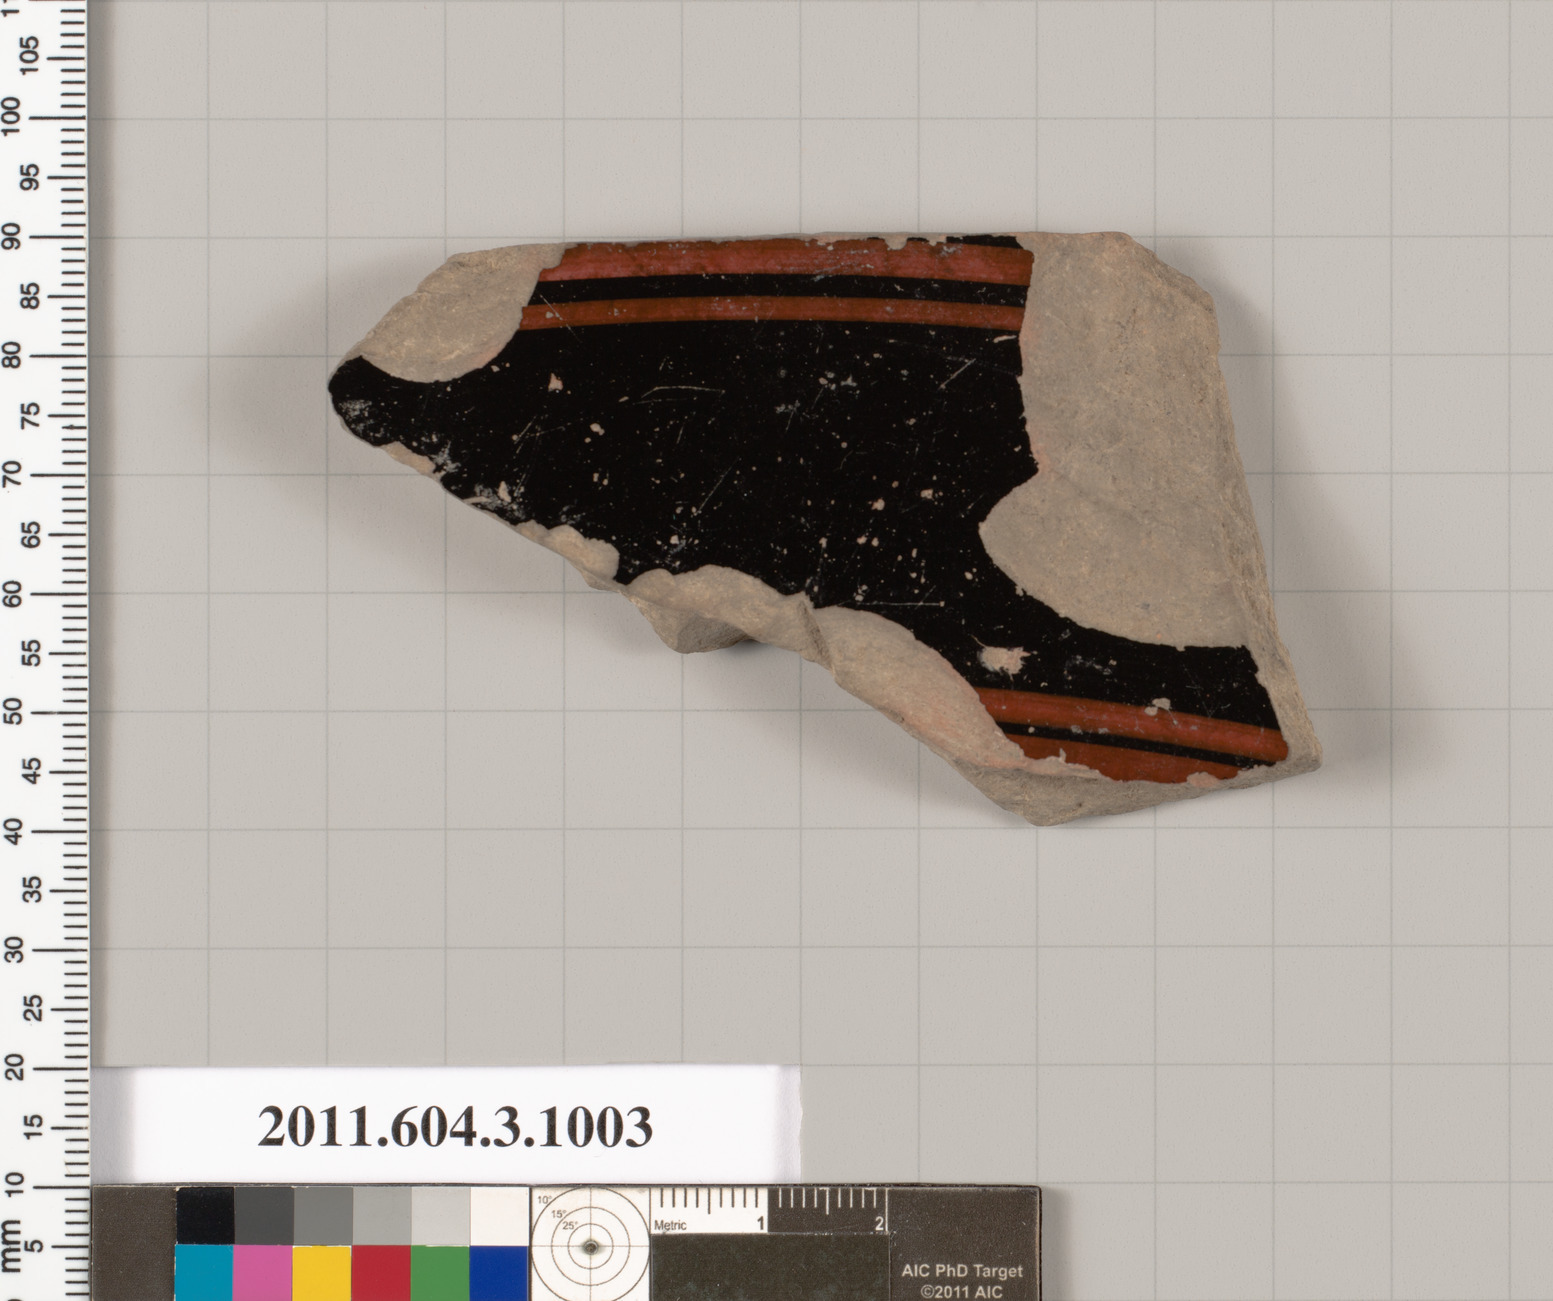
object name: lekanis fragment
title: Terracotta fragment of lekanis (covered dish)?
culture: greek, attic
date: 600-501 BCE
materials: terracotta